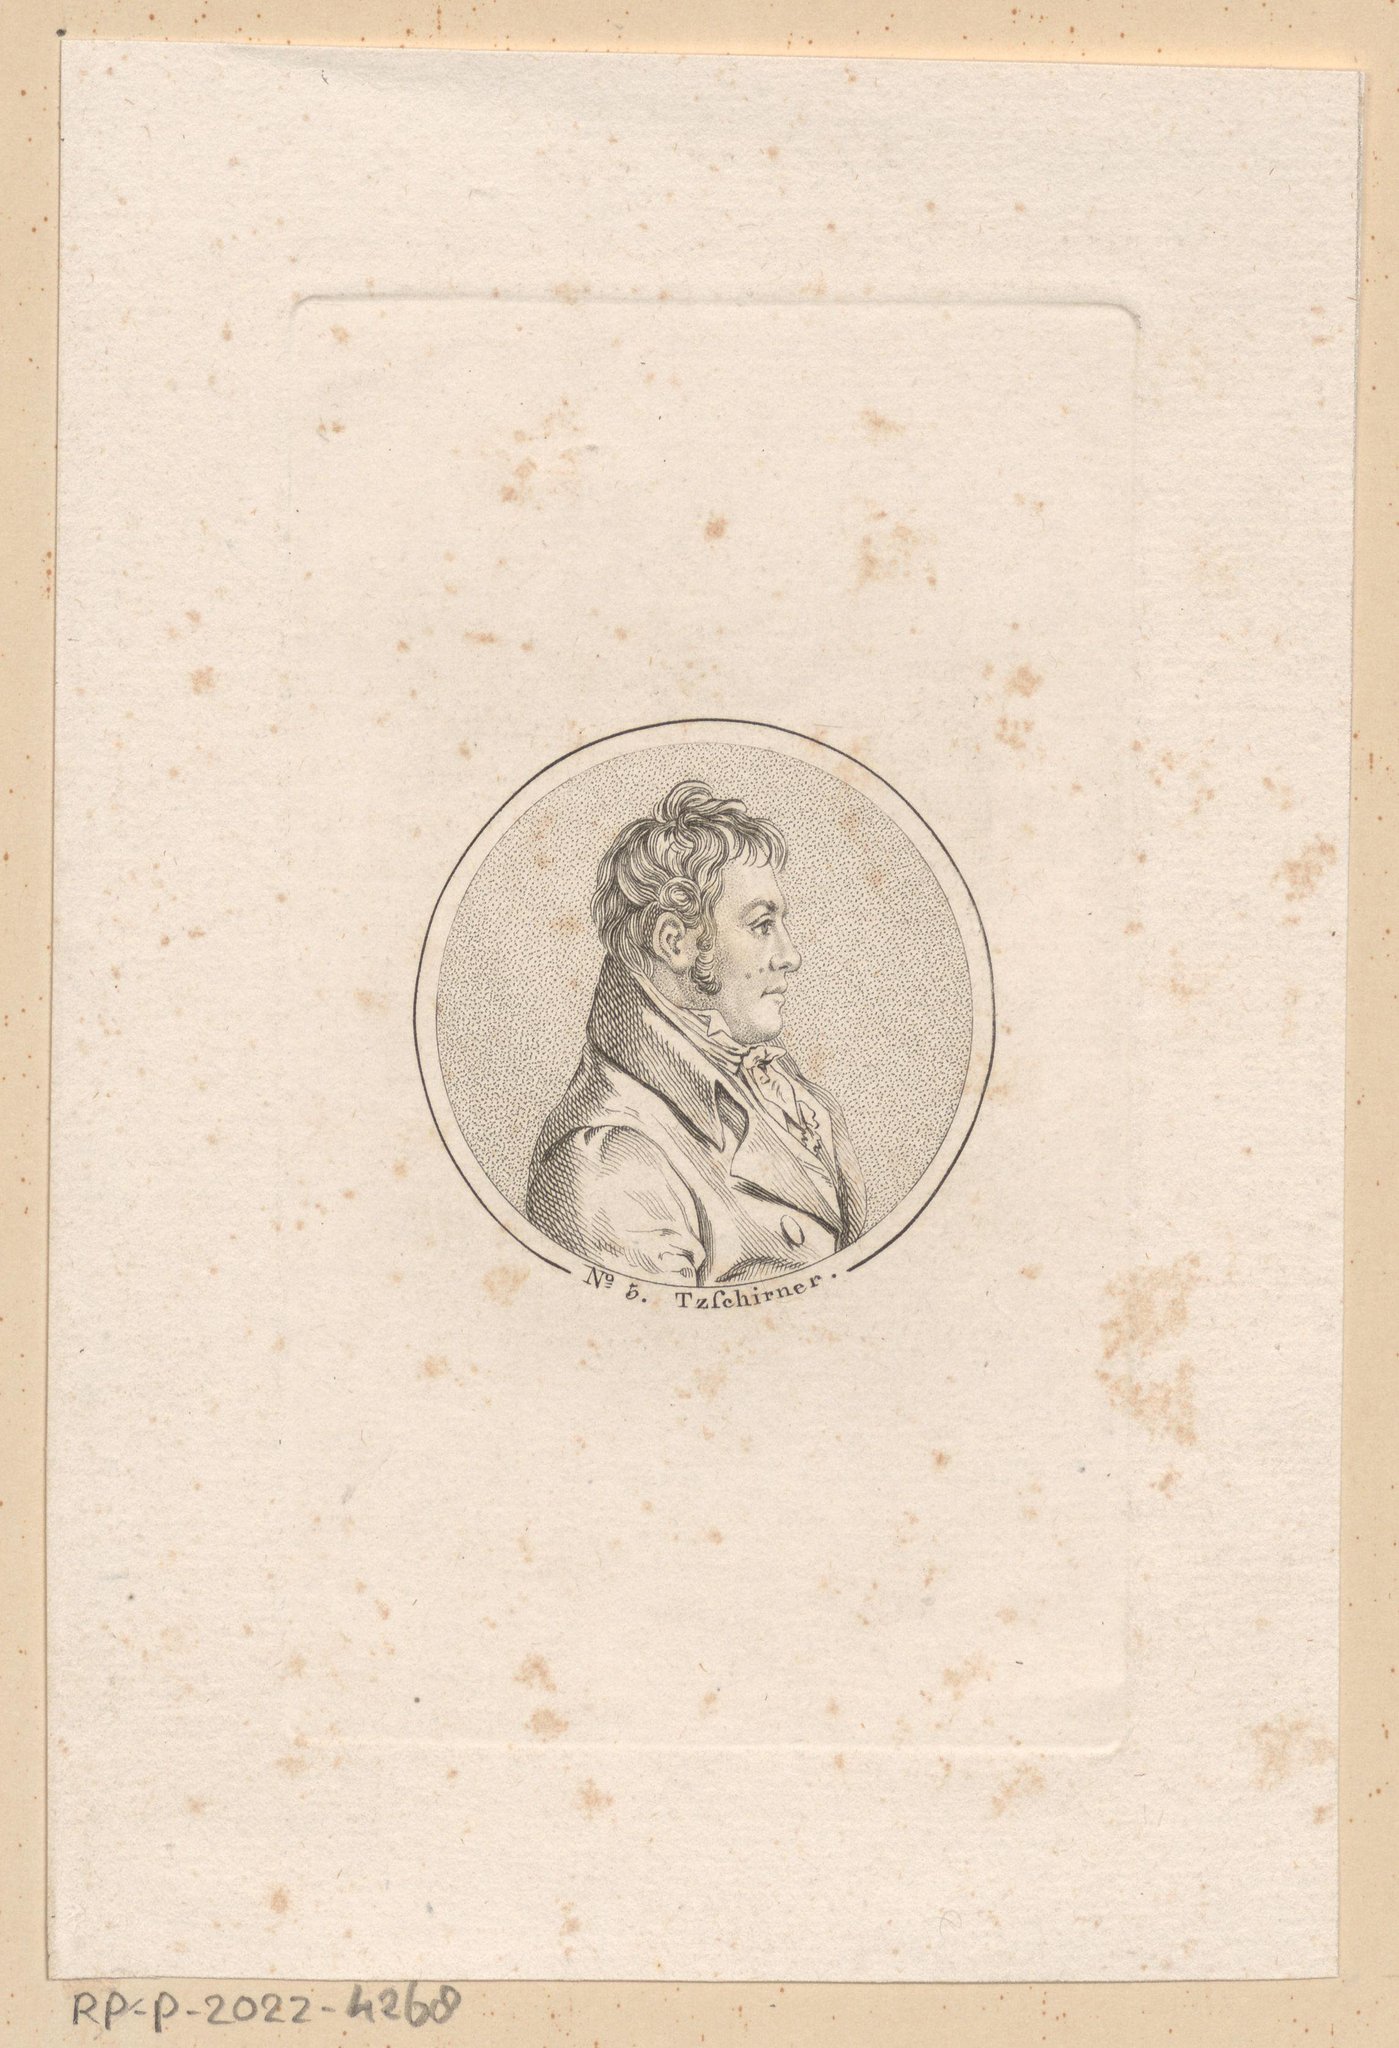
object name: print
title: Portret van Heinrich Gottlieb Tzschirner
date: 1810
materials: paper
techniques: etching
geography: germany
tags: theologian, scholar, philosopher, historical persons, portrait of a writer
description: Prent waarschijnlijk uit: Kreussler, Heinrich Gottlieb. Autobiographieen Leipziger Gelehrten. Leipzig: J.B. Fleischer, 1810.